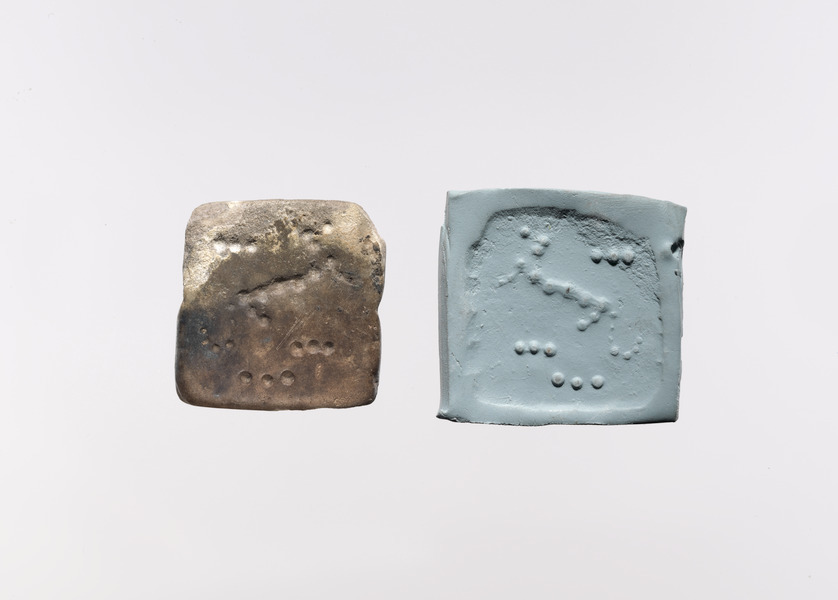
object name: stamp seal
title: Drilled square plaque seal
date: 3500-2900 BCE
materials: stone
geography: mesopotamia